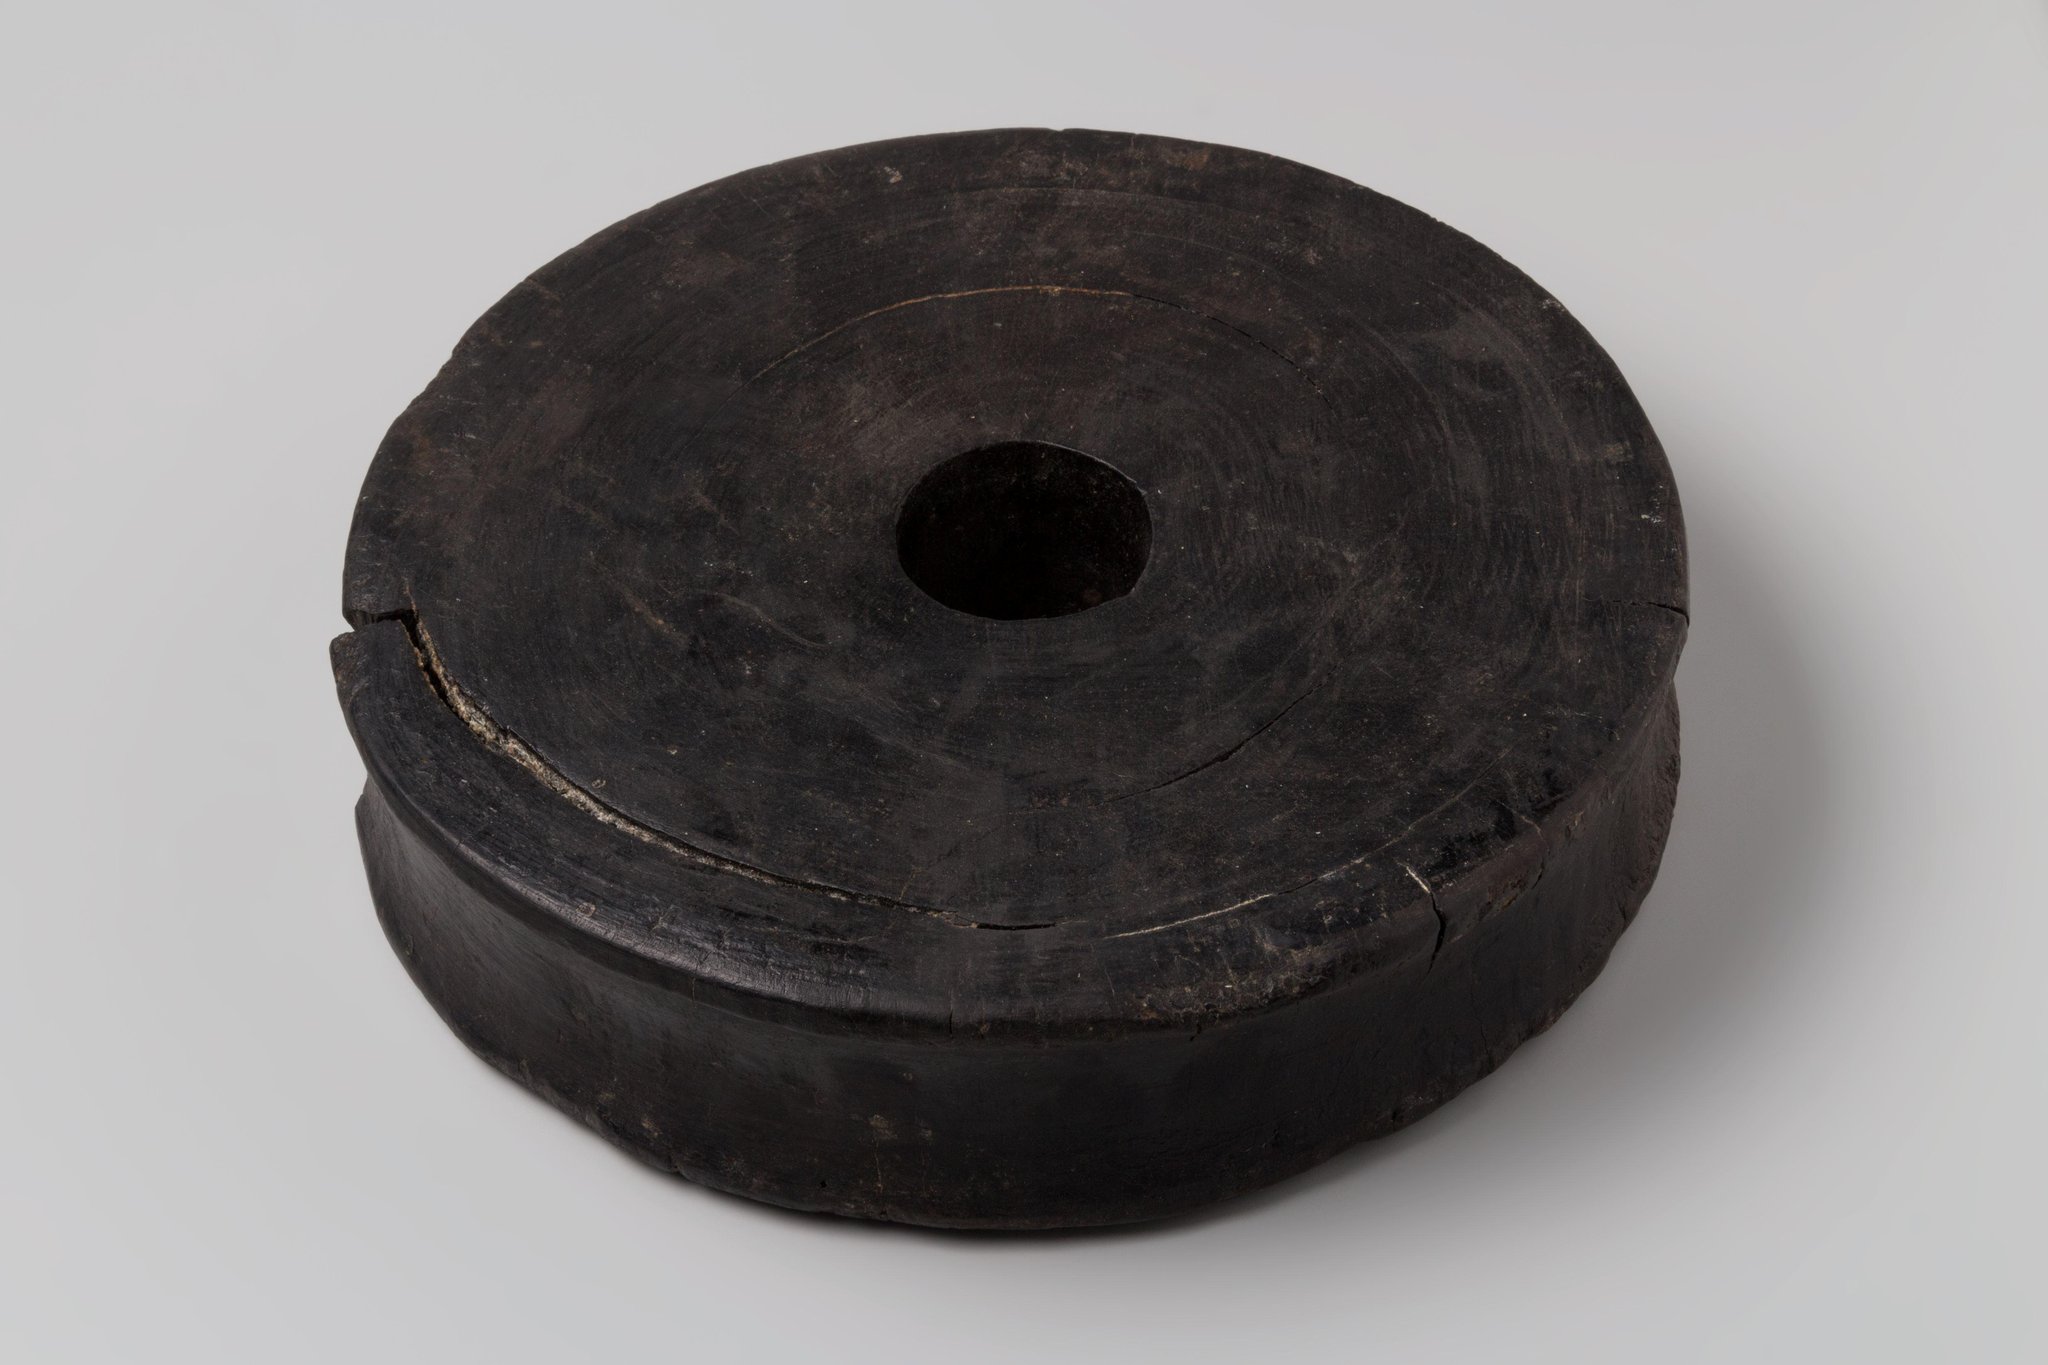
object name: disk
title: Schijf uit V.O.C.-schip de 'Witte Leeuw'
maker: Anonymous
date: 1613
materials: wood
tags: verenigde oostindische compagnie, sint-helena